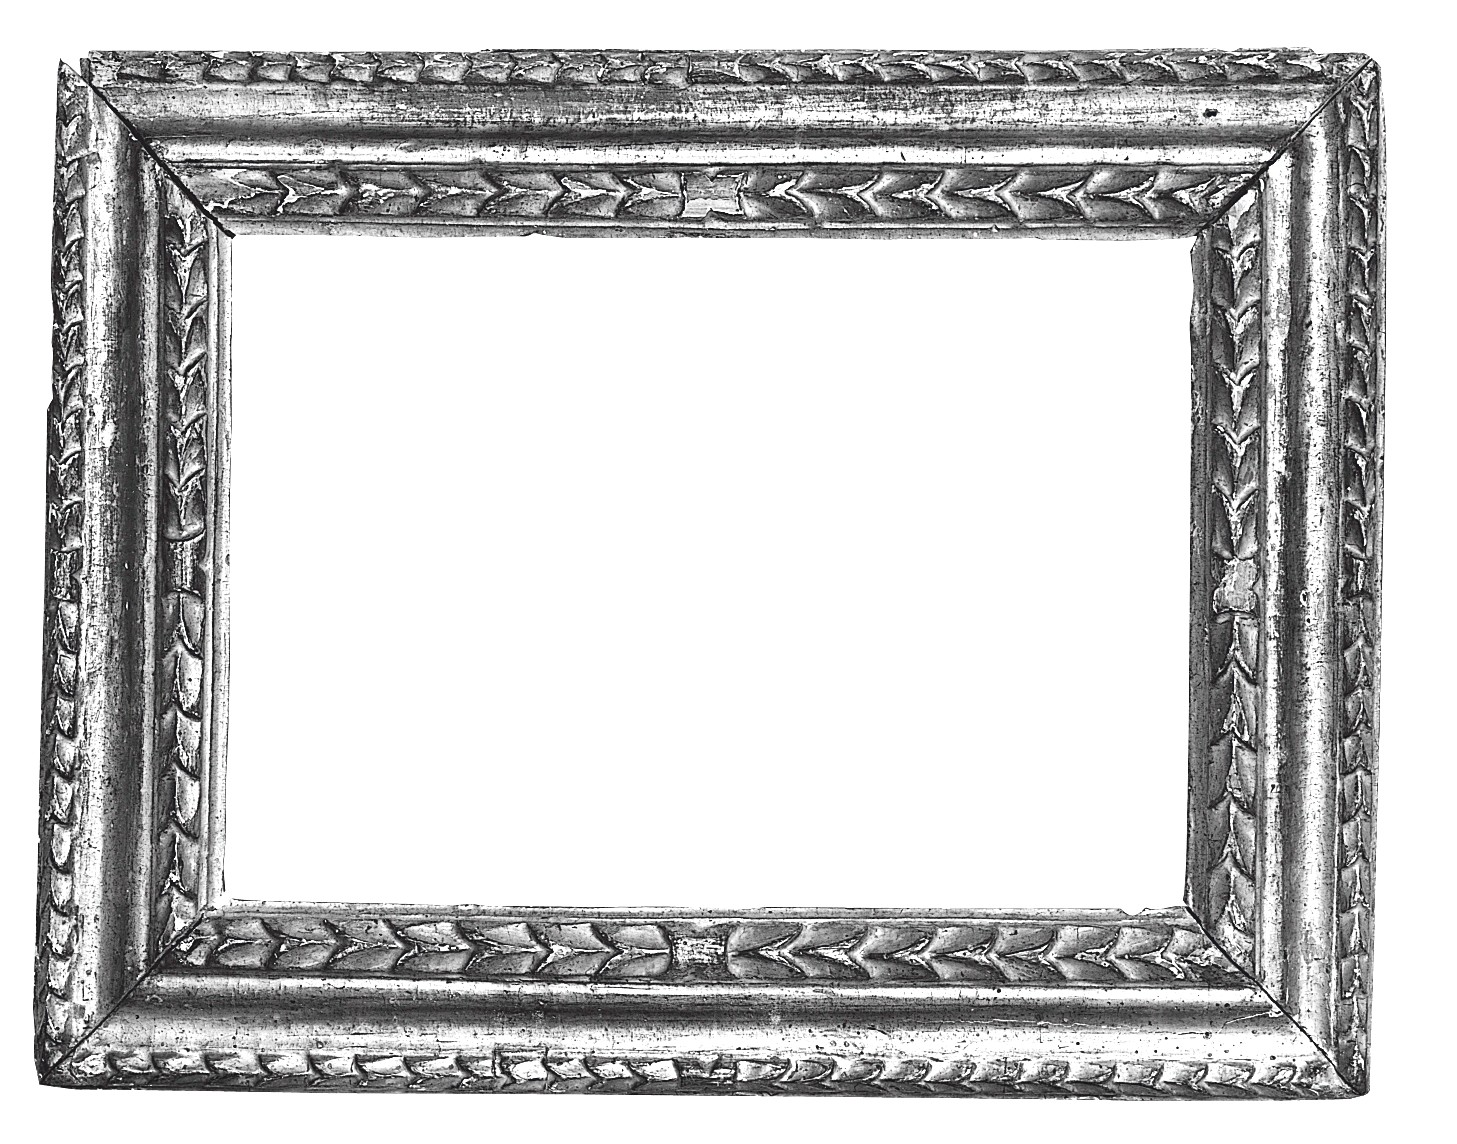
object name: frame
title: Reverse frame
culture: italian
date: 1667-1700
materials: wood